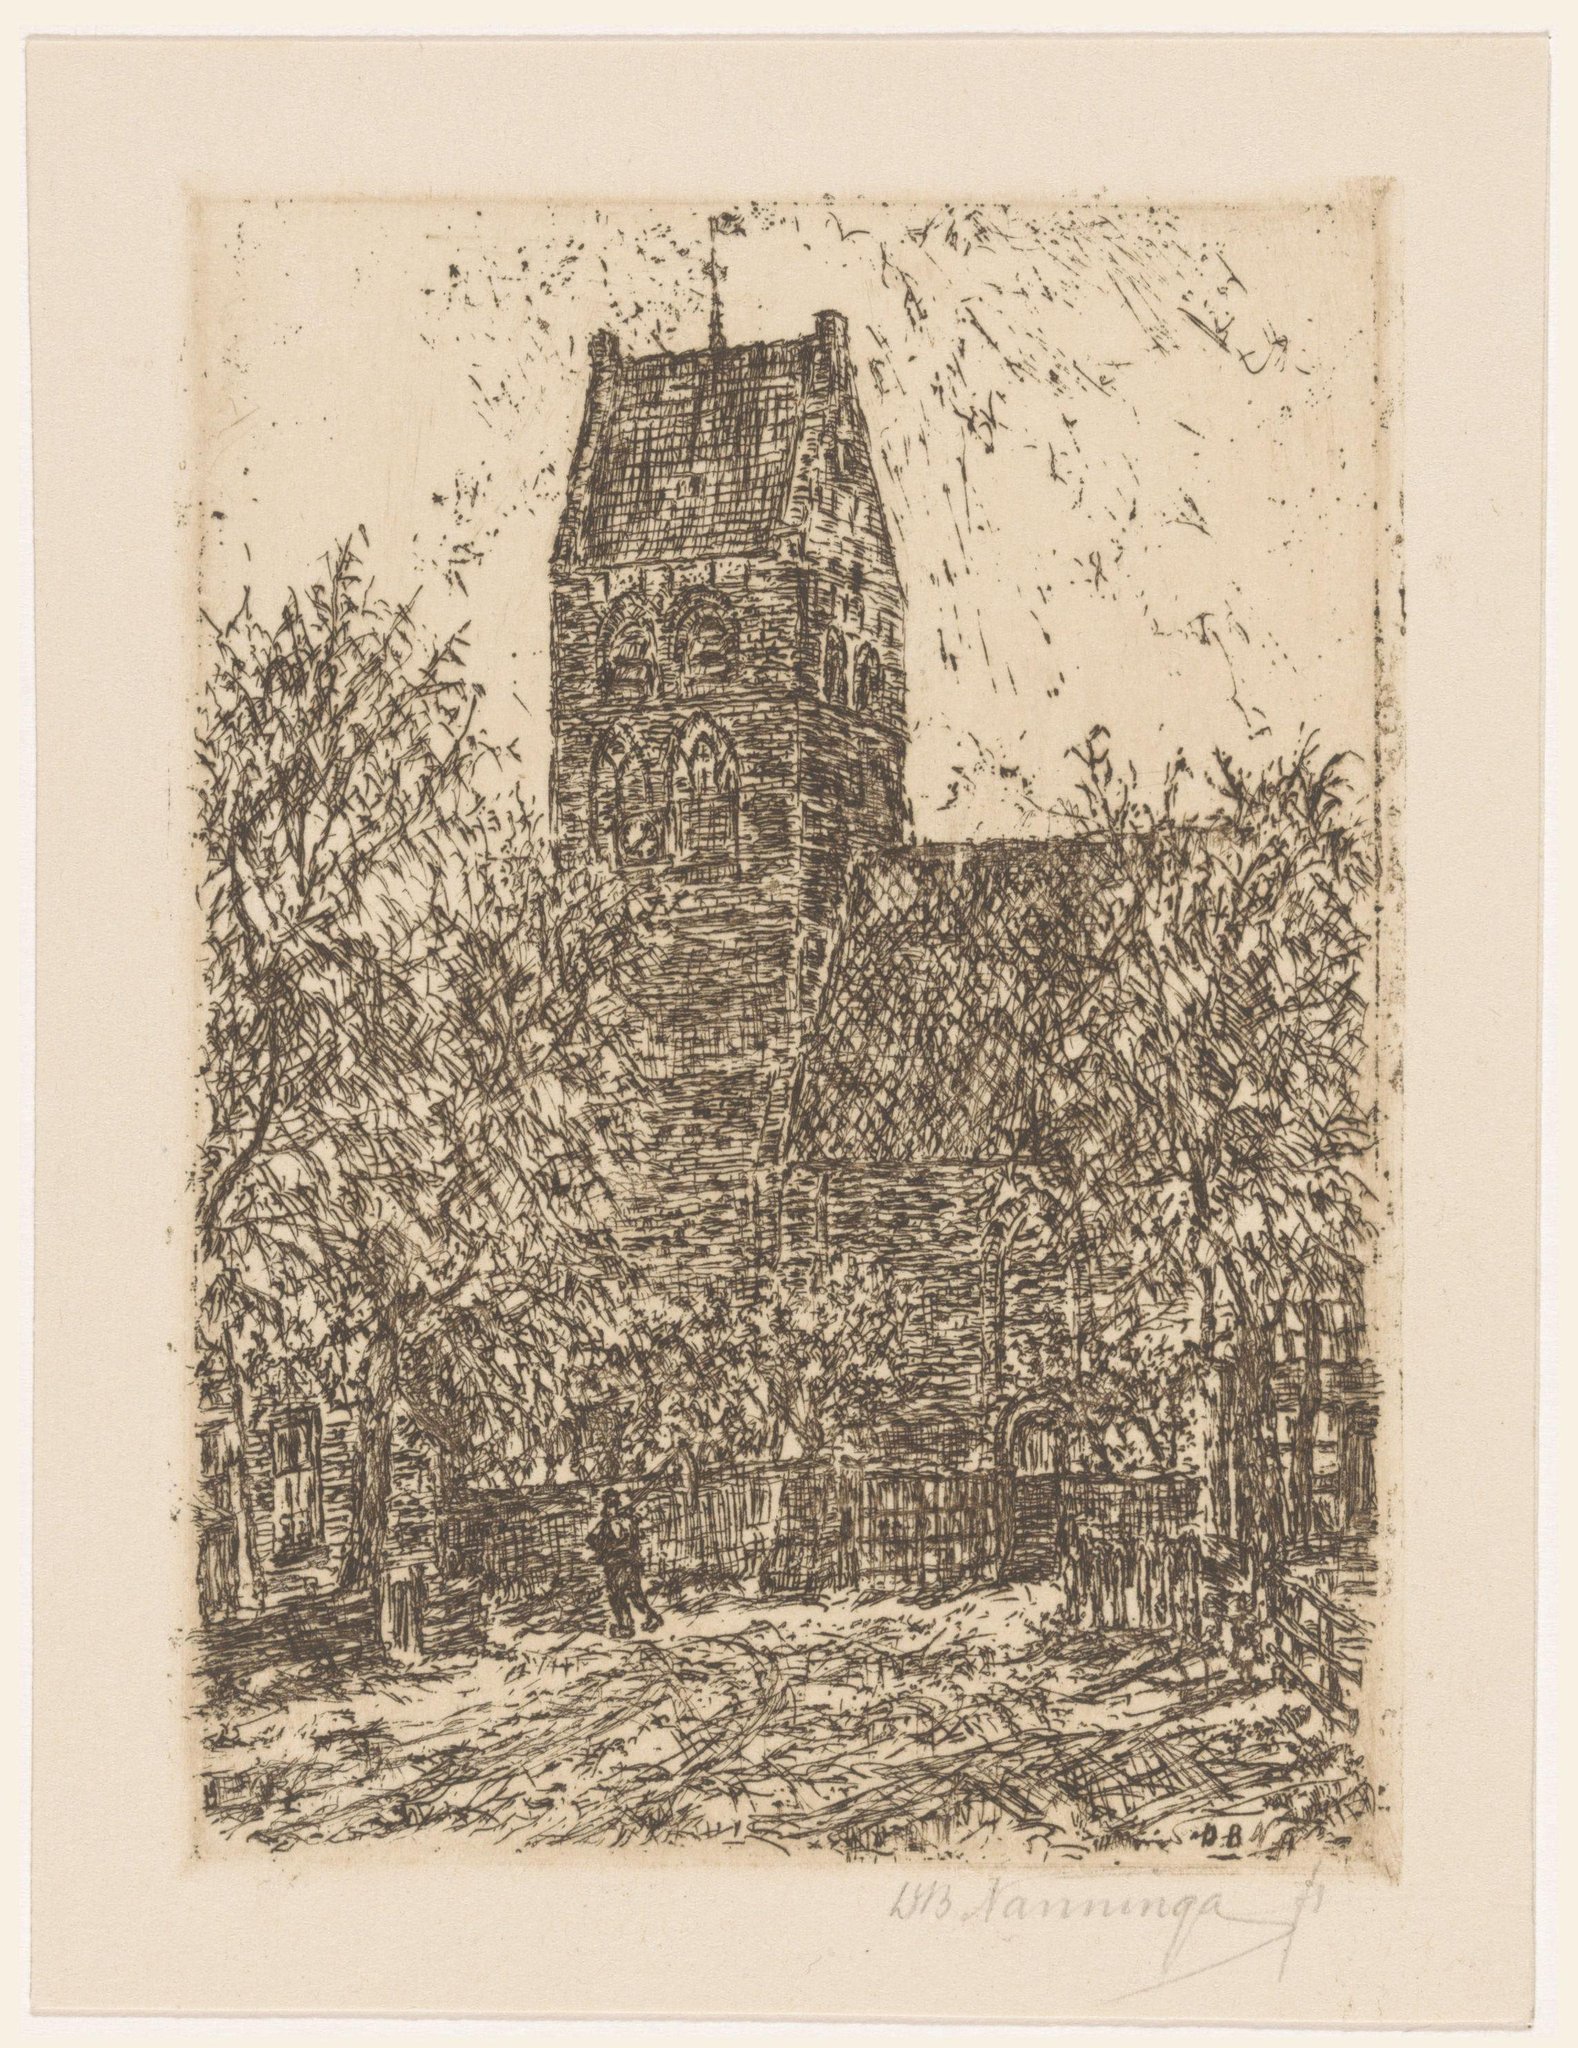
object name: print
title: Dorpskerk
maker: dirk berend nanninga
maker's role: print maker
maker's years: 1868-1954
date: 1878-1931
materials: paper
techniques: etching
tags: church (exterior)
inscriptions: collector's mark: Lugt 2228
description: Voor de kerk loopt een man met een zeis.